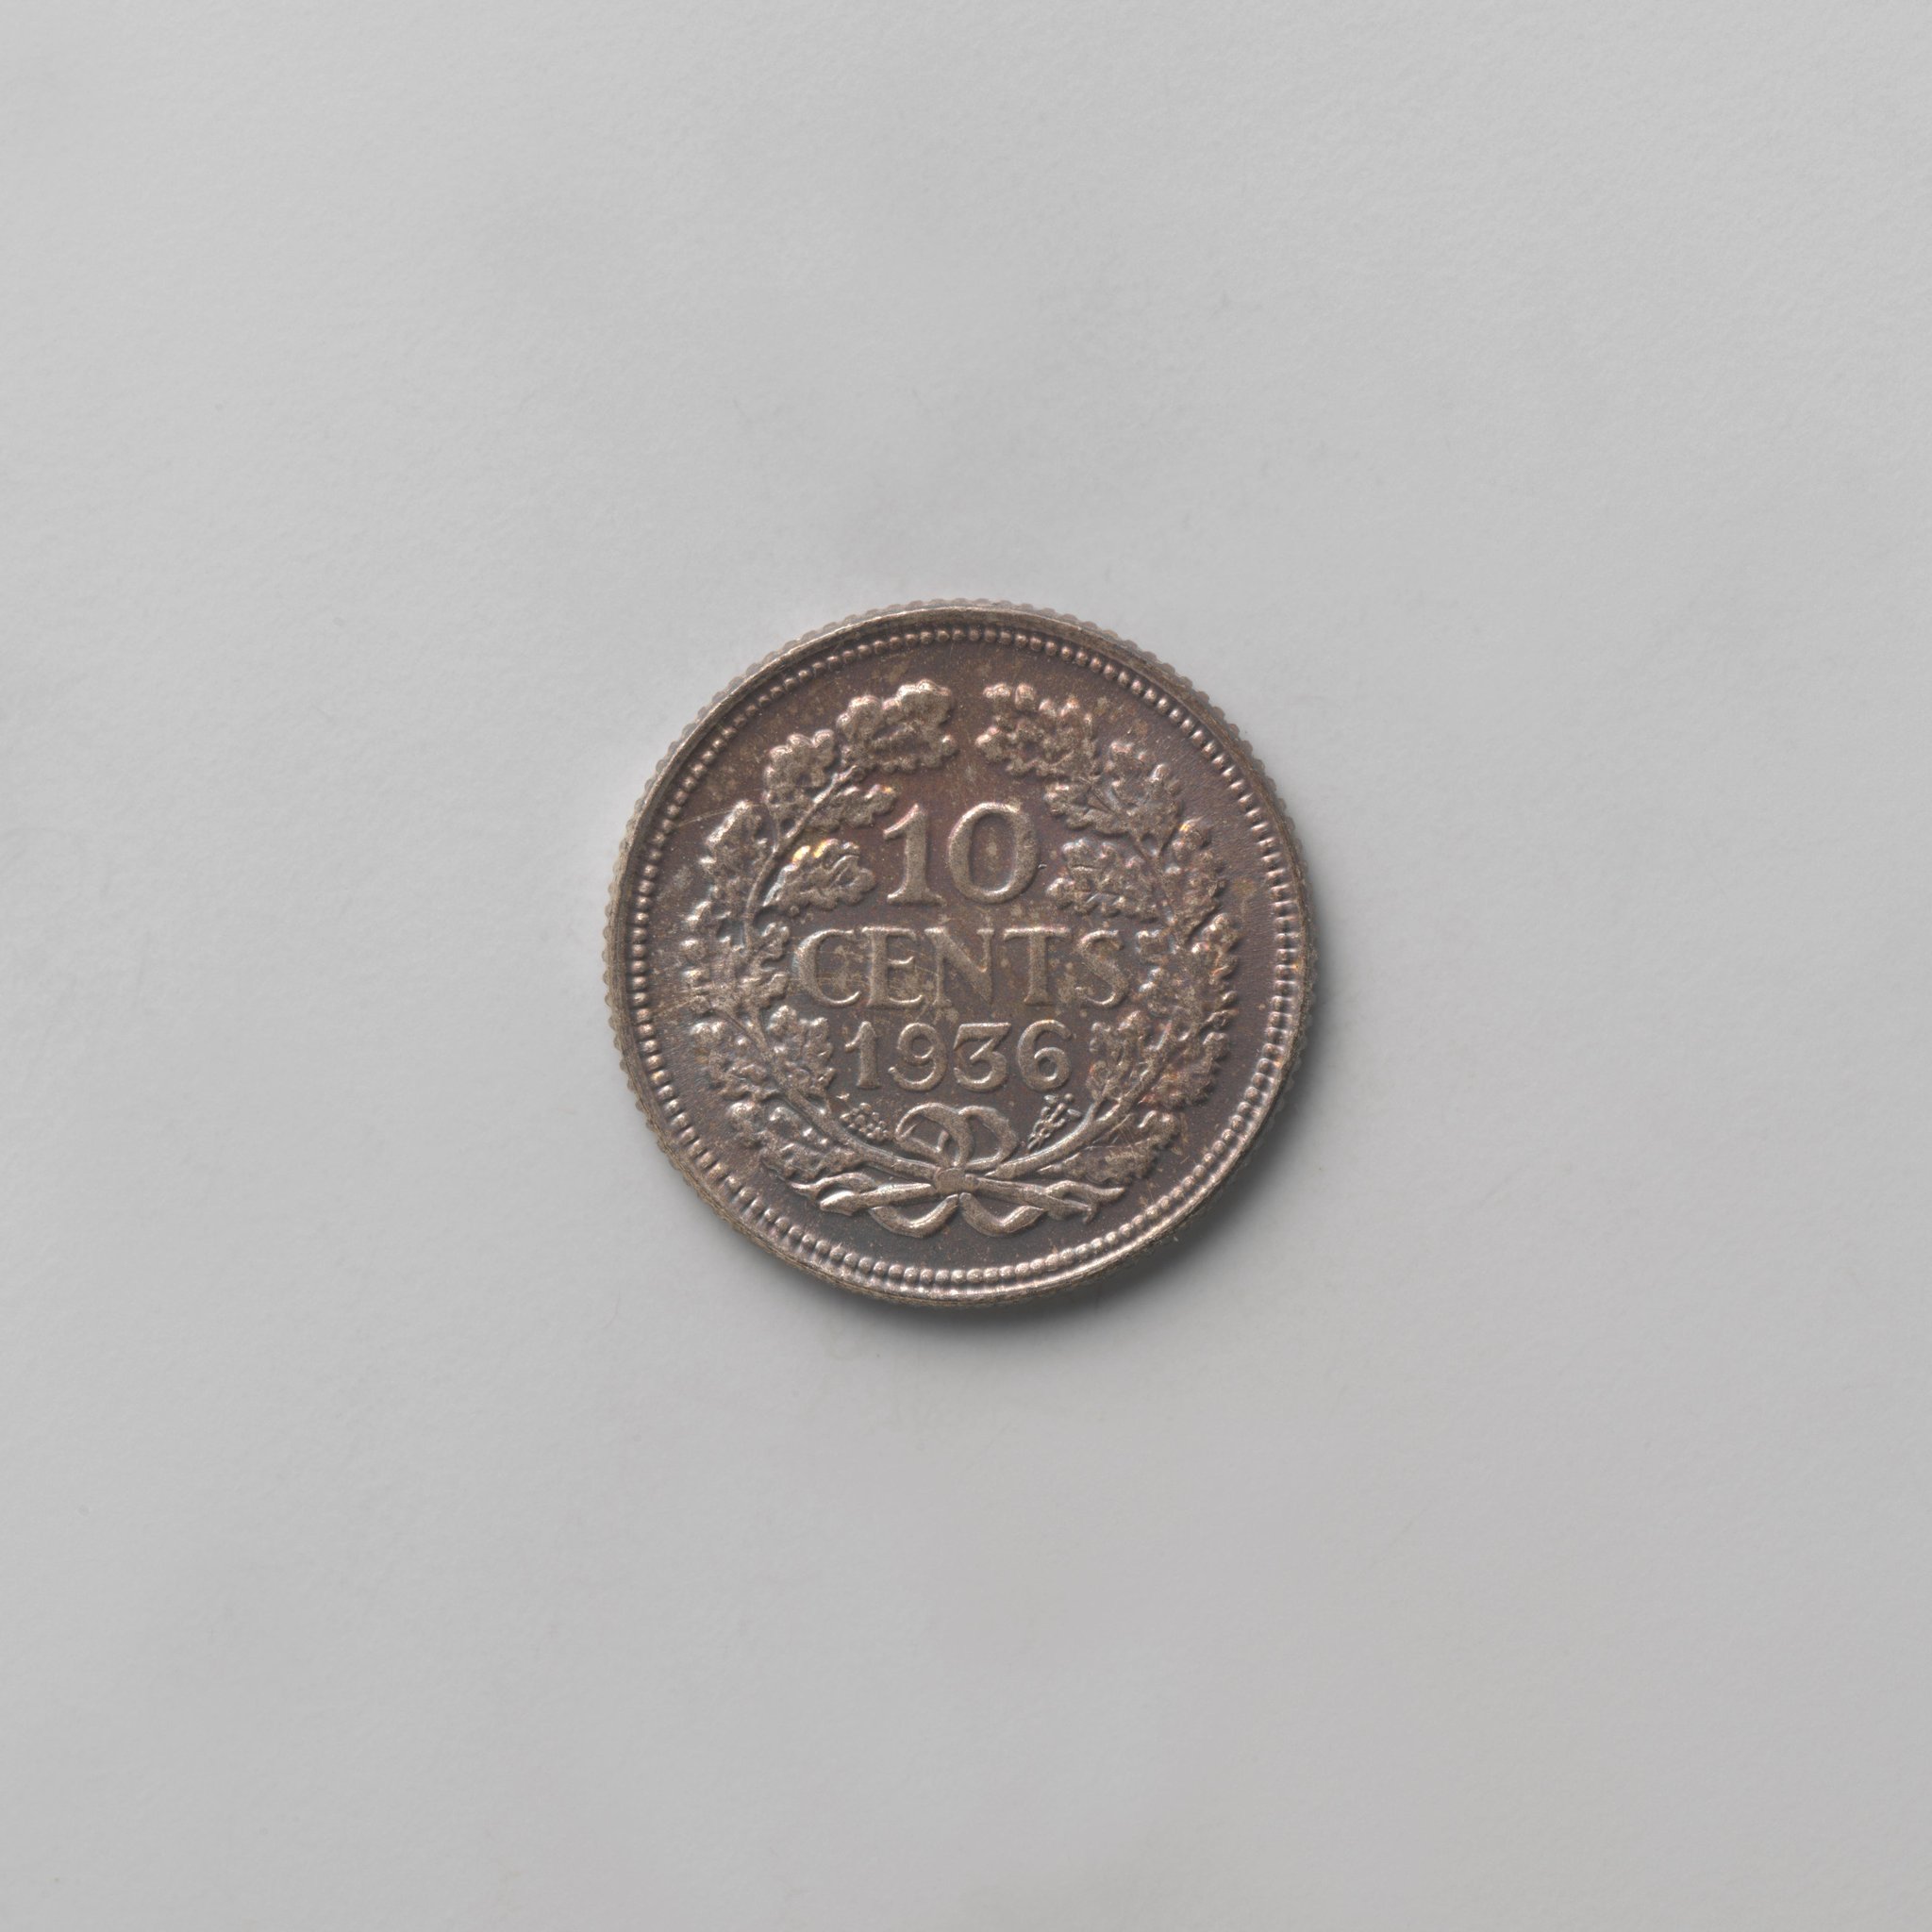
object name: coin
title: Nederlandse10 cent,1936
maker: wilhelmina of the netherlands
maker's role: print maker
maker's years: 1880-1962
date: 1936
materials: silver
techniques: striking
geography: utrecht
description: Zilveren munt. Voorzijde: hoofd naar links. Keerzijde: binnen twee samengebonden eiketakken waarde-aanduiding 10 cents en jaartal. Kartelrand.